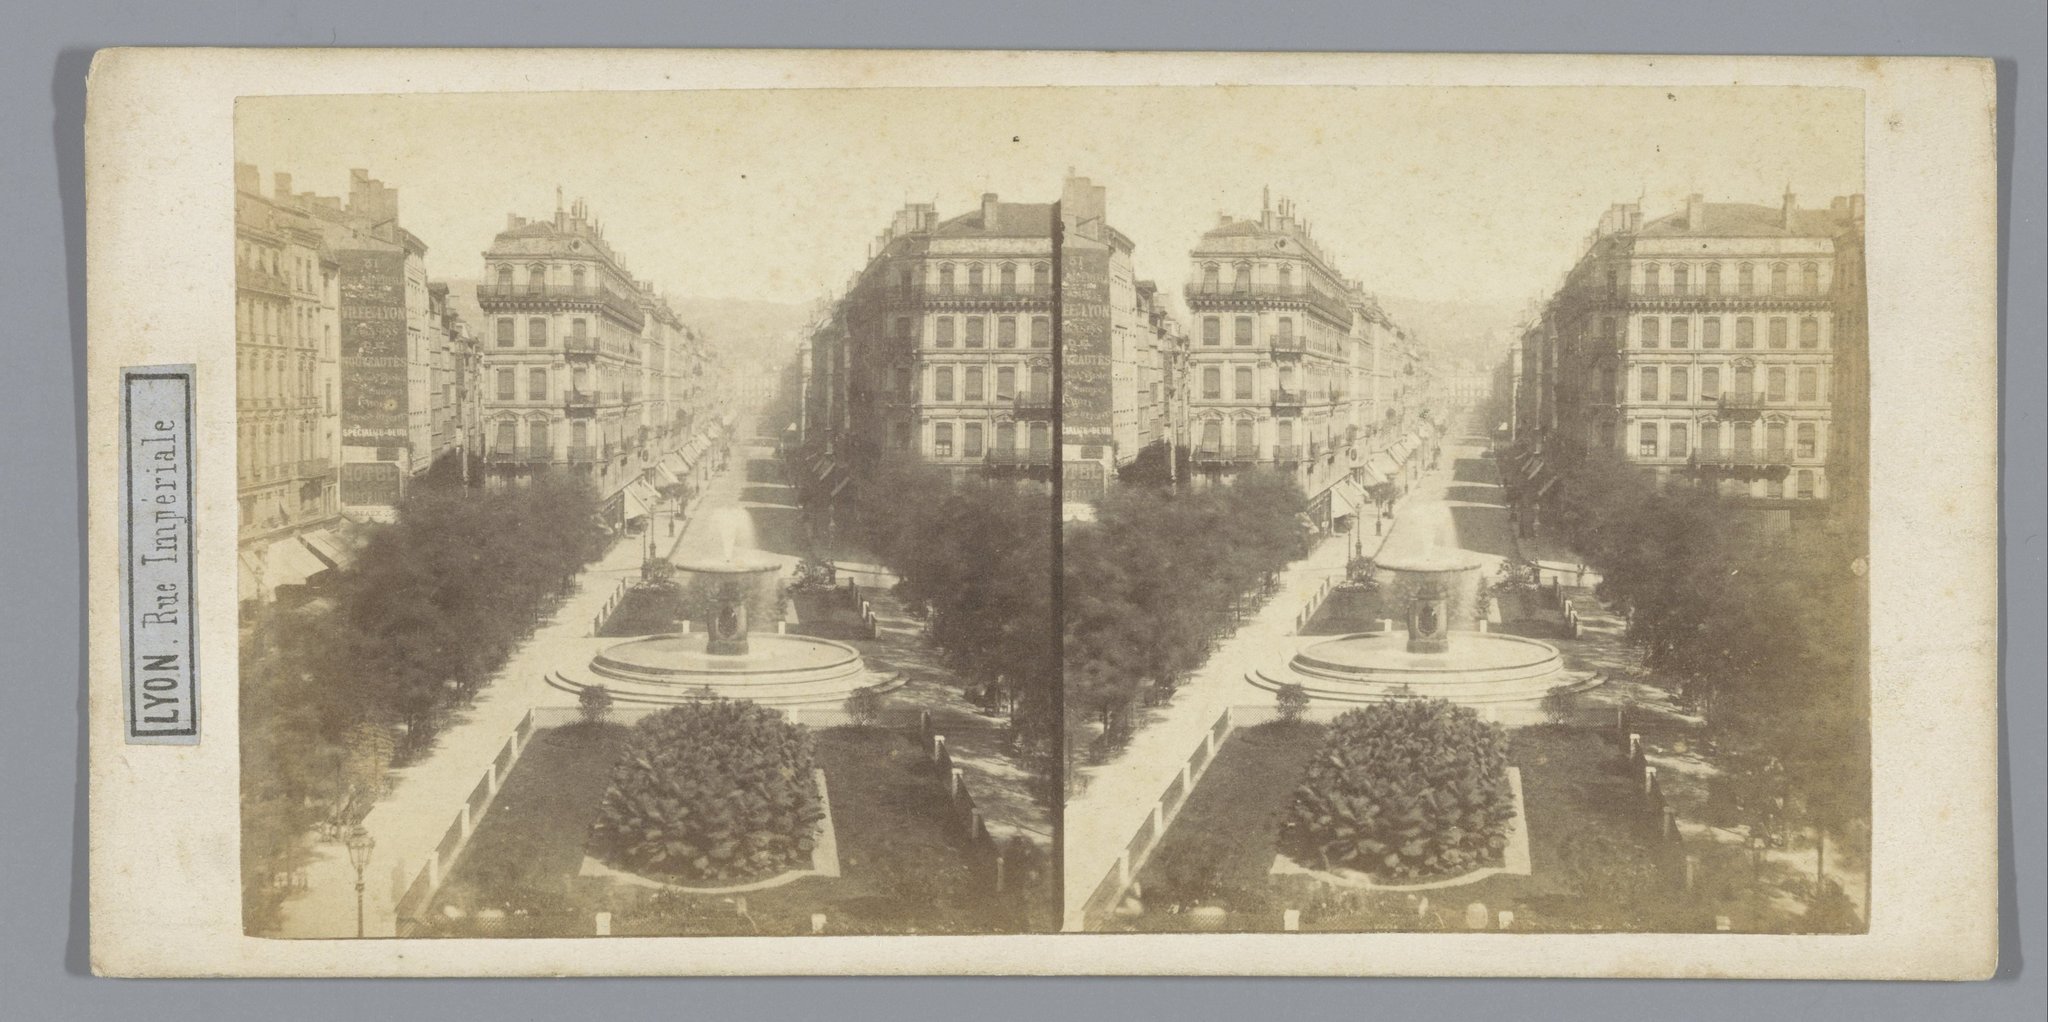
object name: stereograph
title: Gezicht op de Rue Impériale te Lyon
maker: fourvières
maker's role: fotograaf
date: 1855-1865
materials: cardboard, photographic support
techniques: albumen print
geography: lyon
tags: street